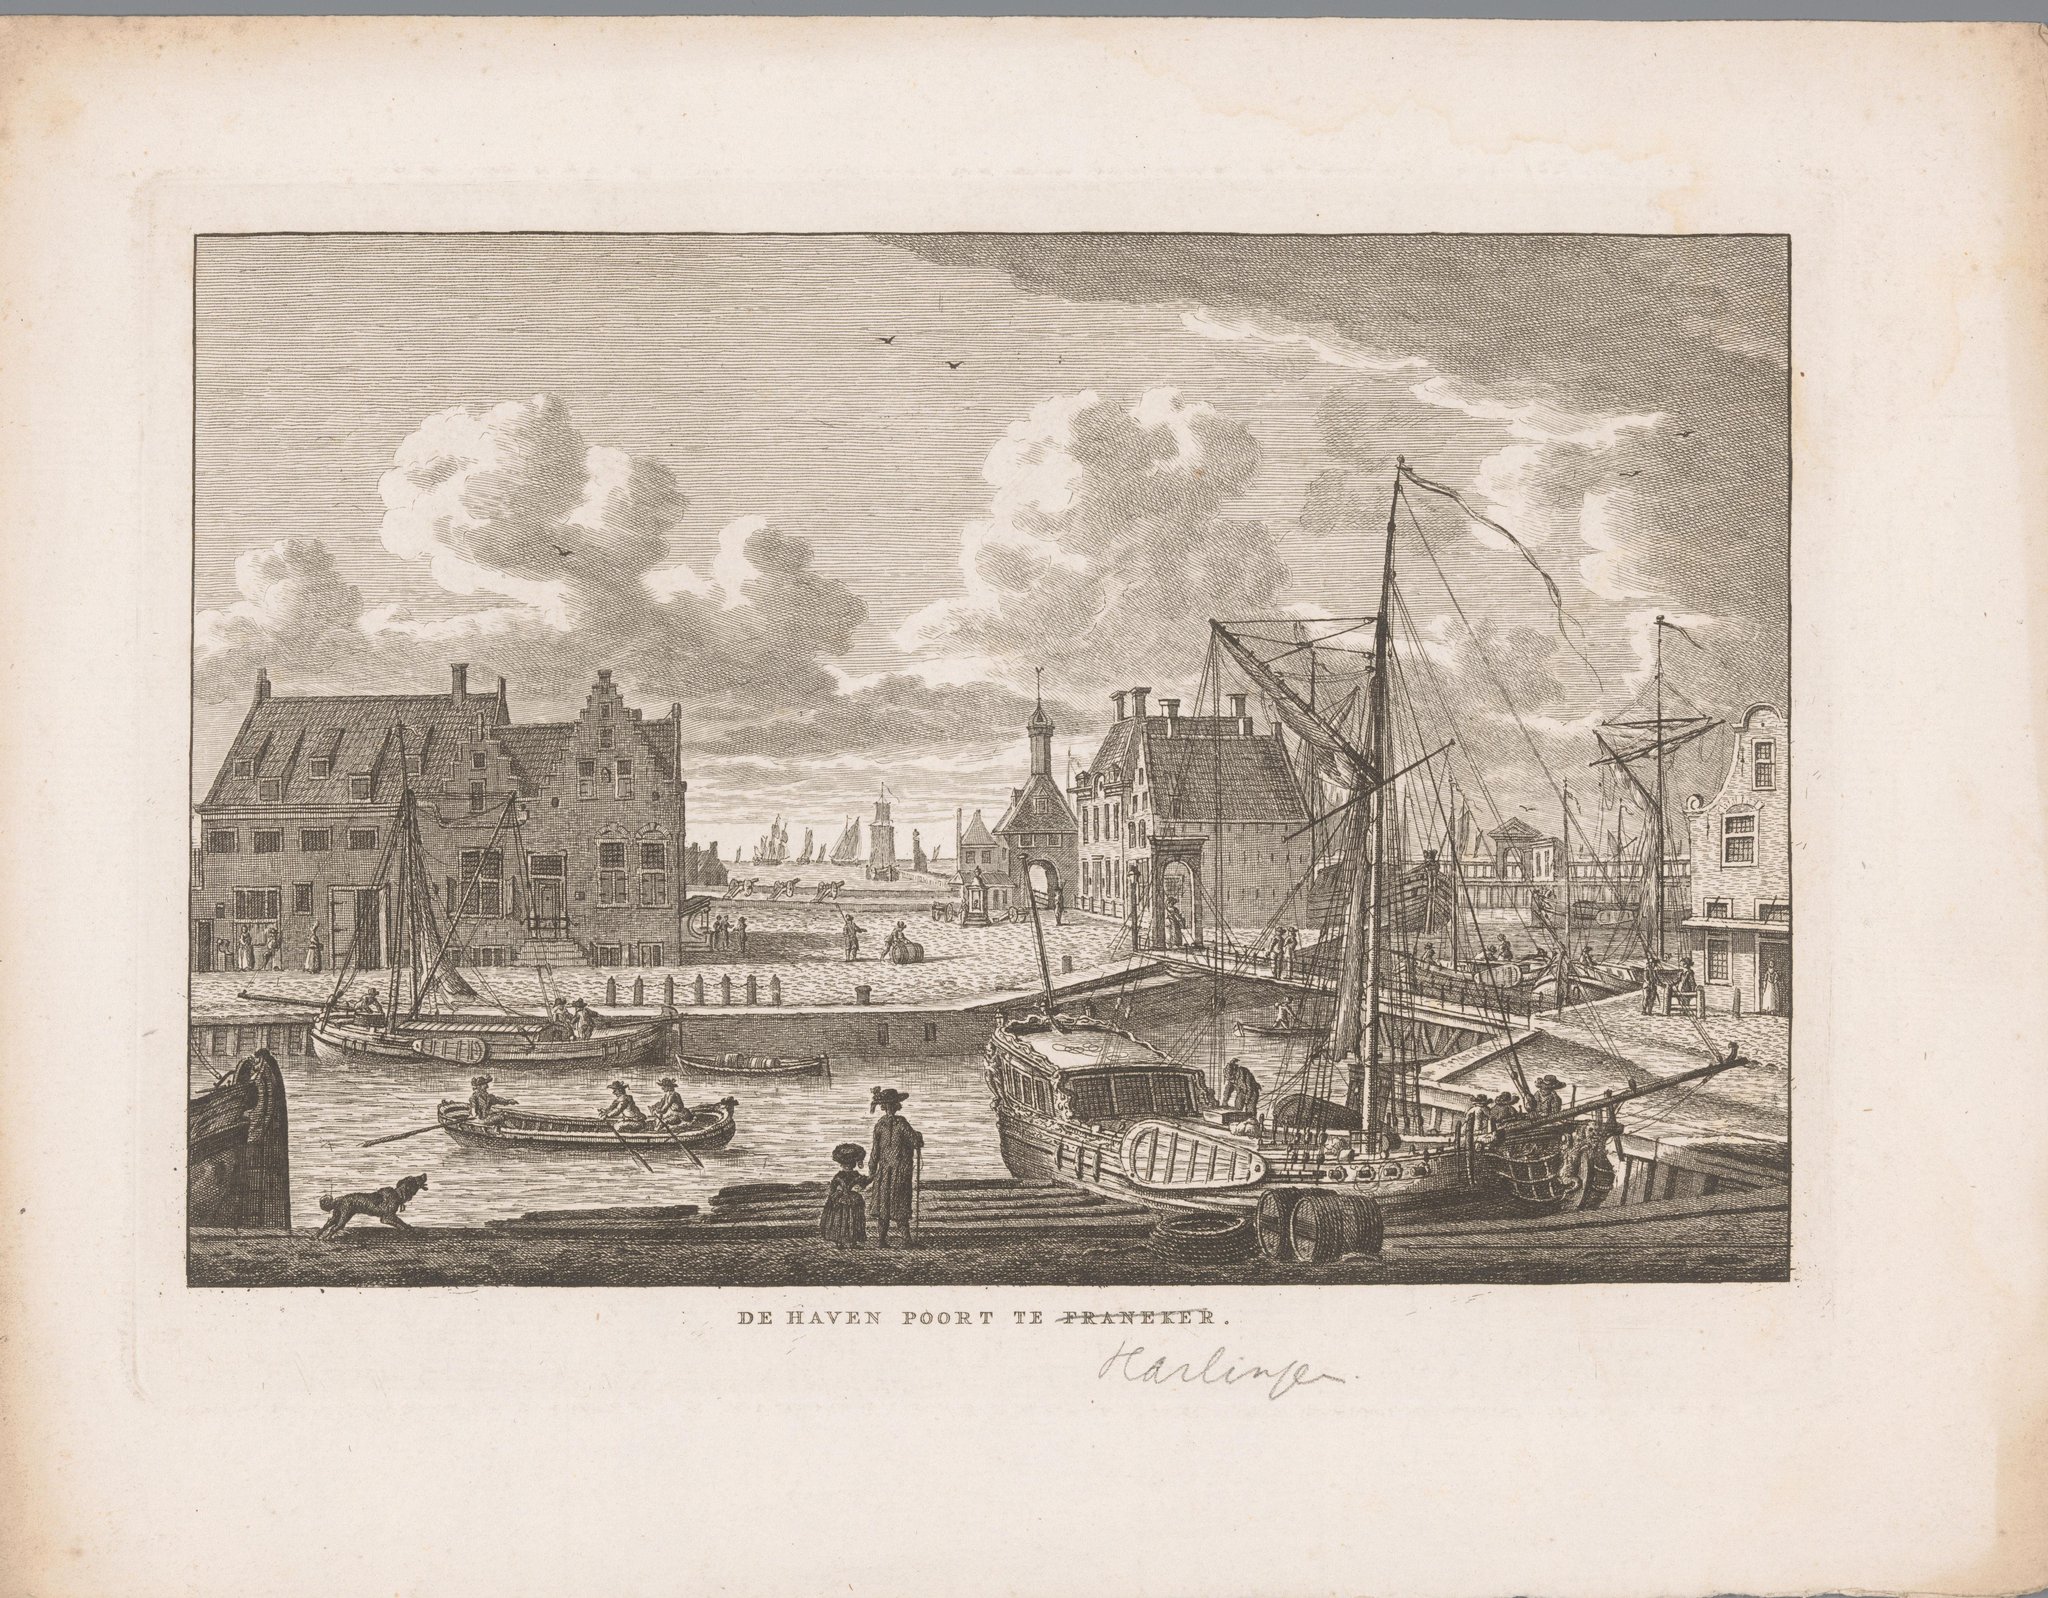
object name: print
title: De Haven Poort te Franeker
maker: carel frederik bendorp (i)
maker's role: print maker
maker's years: 1736-1814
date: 1786-1792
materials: paper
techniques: etching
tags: harbour, city-view, and landscape with man-made constructions, harlingen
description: Afgebeeld is niet de havenpoort van Franeker, zoals in de titel vermeld, maar die van Harlingen. Prent uit: Vaderlandsche gezichten, of afbeeldingen van den tegenwoordigen staat der Vereenigde Nederlanden (…). Amsterdam: Hendrik Gartman, Willem Vermandel en Jan Willem Smit, 1786-1792. Uitgegeven in afleveringen met ieder een eigen bifolium en inhoudsopgave. Alle prenten in deze publicatie zijn gegraveerd door Carel Frederik Bendorp (I) en, in de meeste gevallen, gebaseerd op tekeningen van Jan Bulthuis.